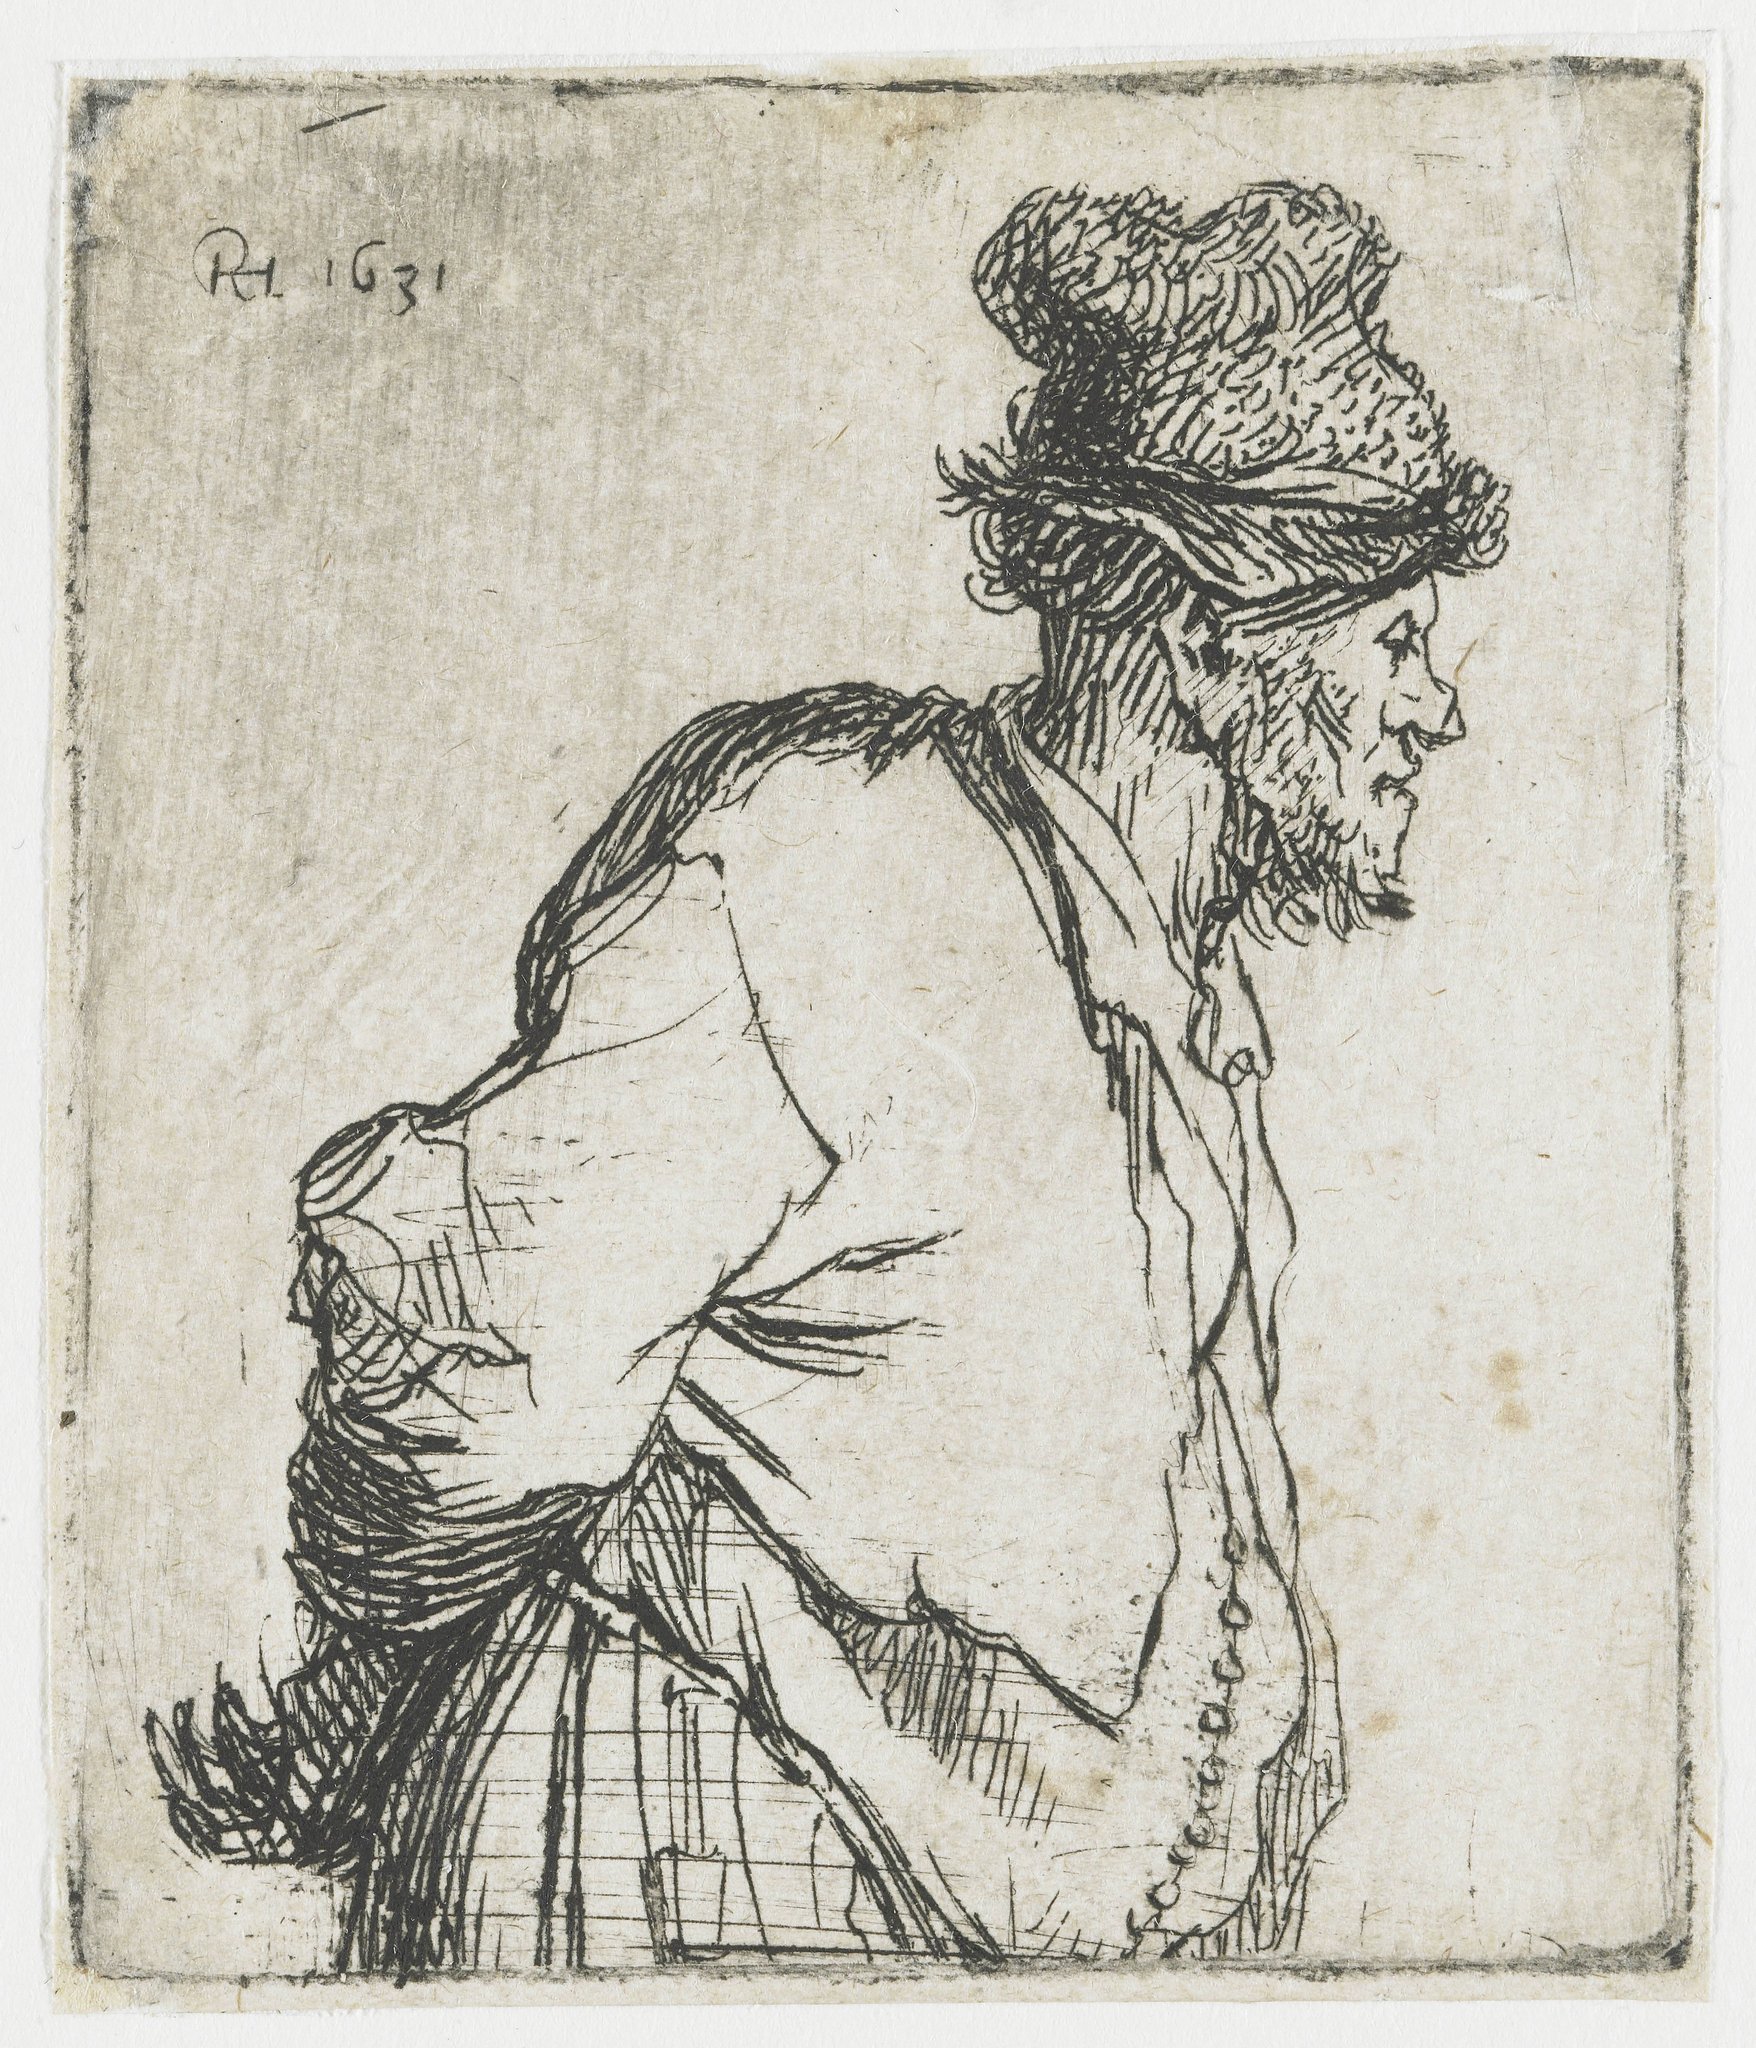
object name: print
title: Peasant with his hands behind his back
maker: rembrandt van rijn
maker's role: draughtsman, painter, print maker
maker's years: 1606-1669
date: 1629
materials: paper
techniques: etching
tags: adult man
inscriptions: monogram and date: ‘RHL 1631’, collector's mark: Lugt 240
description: Rembrandt’s rapid progress as a printmaker is easy to see in this group of poor wretches. The seated woman is still somewhat crudely executed, but the beggar woman with a gourd and her male companion already testify to greater mastery of the technique. The little prints of a man and a woman are etched in the finer style that Rembrandt was to develop later.